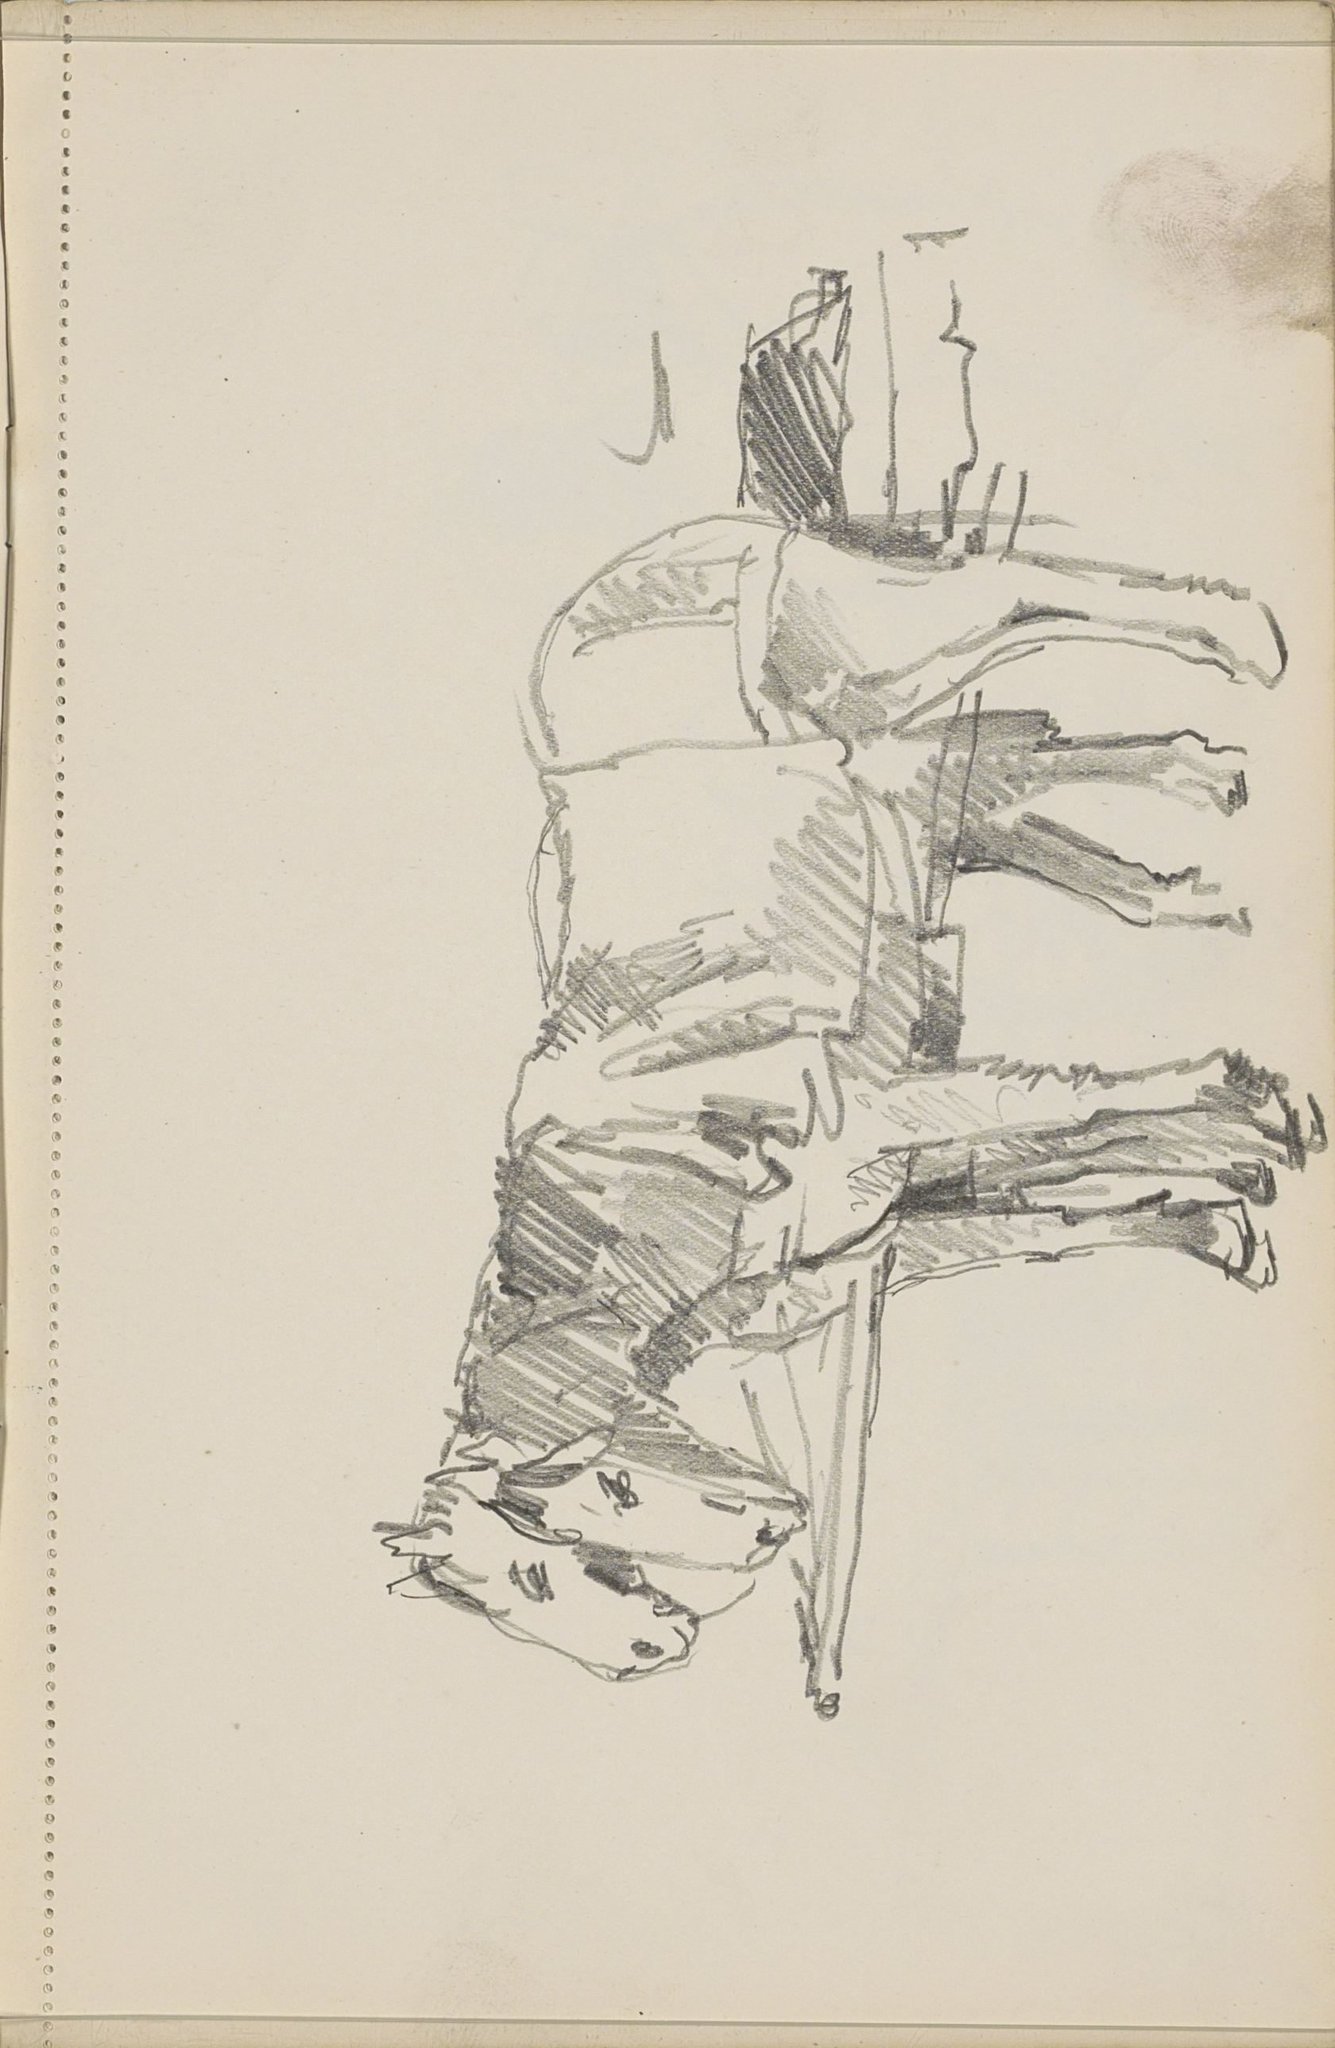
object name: sketchbook leaf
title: Twee trekpaarden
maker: cornelis vreedenburgh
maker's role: draughtsman, print maker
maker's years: 1880-1946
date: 1890-1946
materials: paper, pencil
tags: animal traction, animal-drawn vehicle (carriage etc.), horse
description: Blad 22 recto uit een schetsboek met 59 bladen.